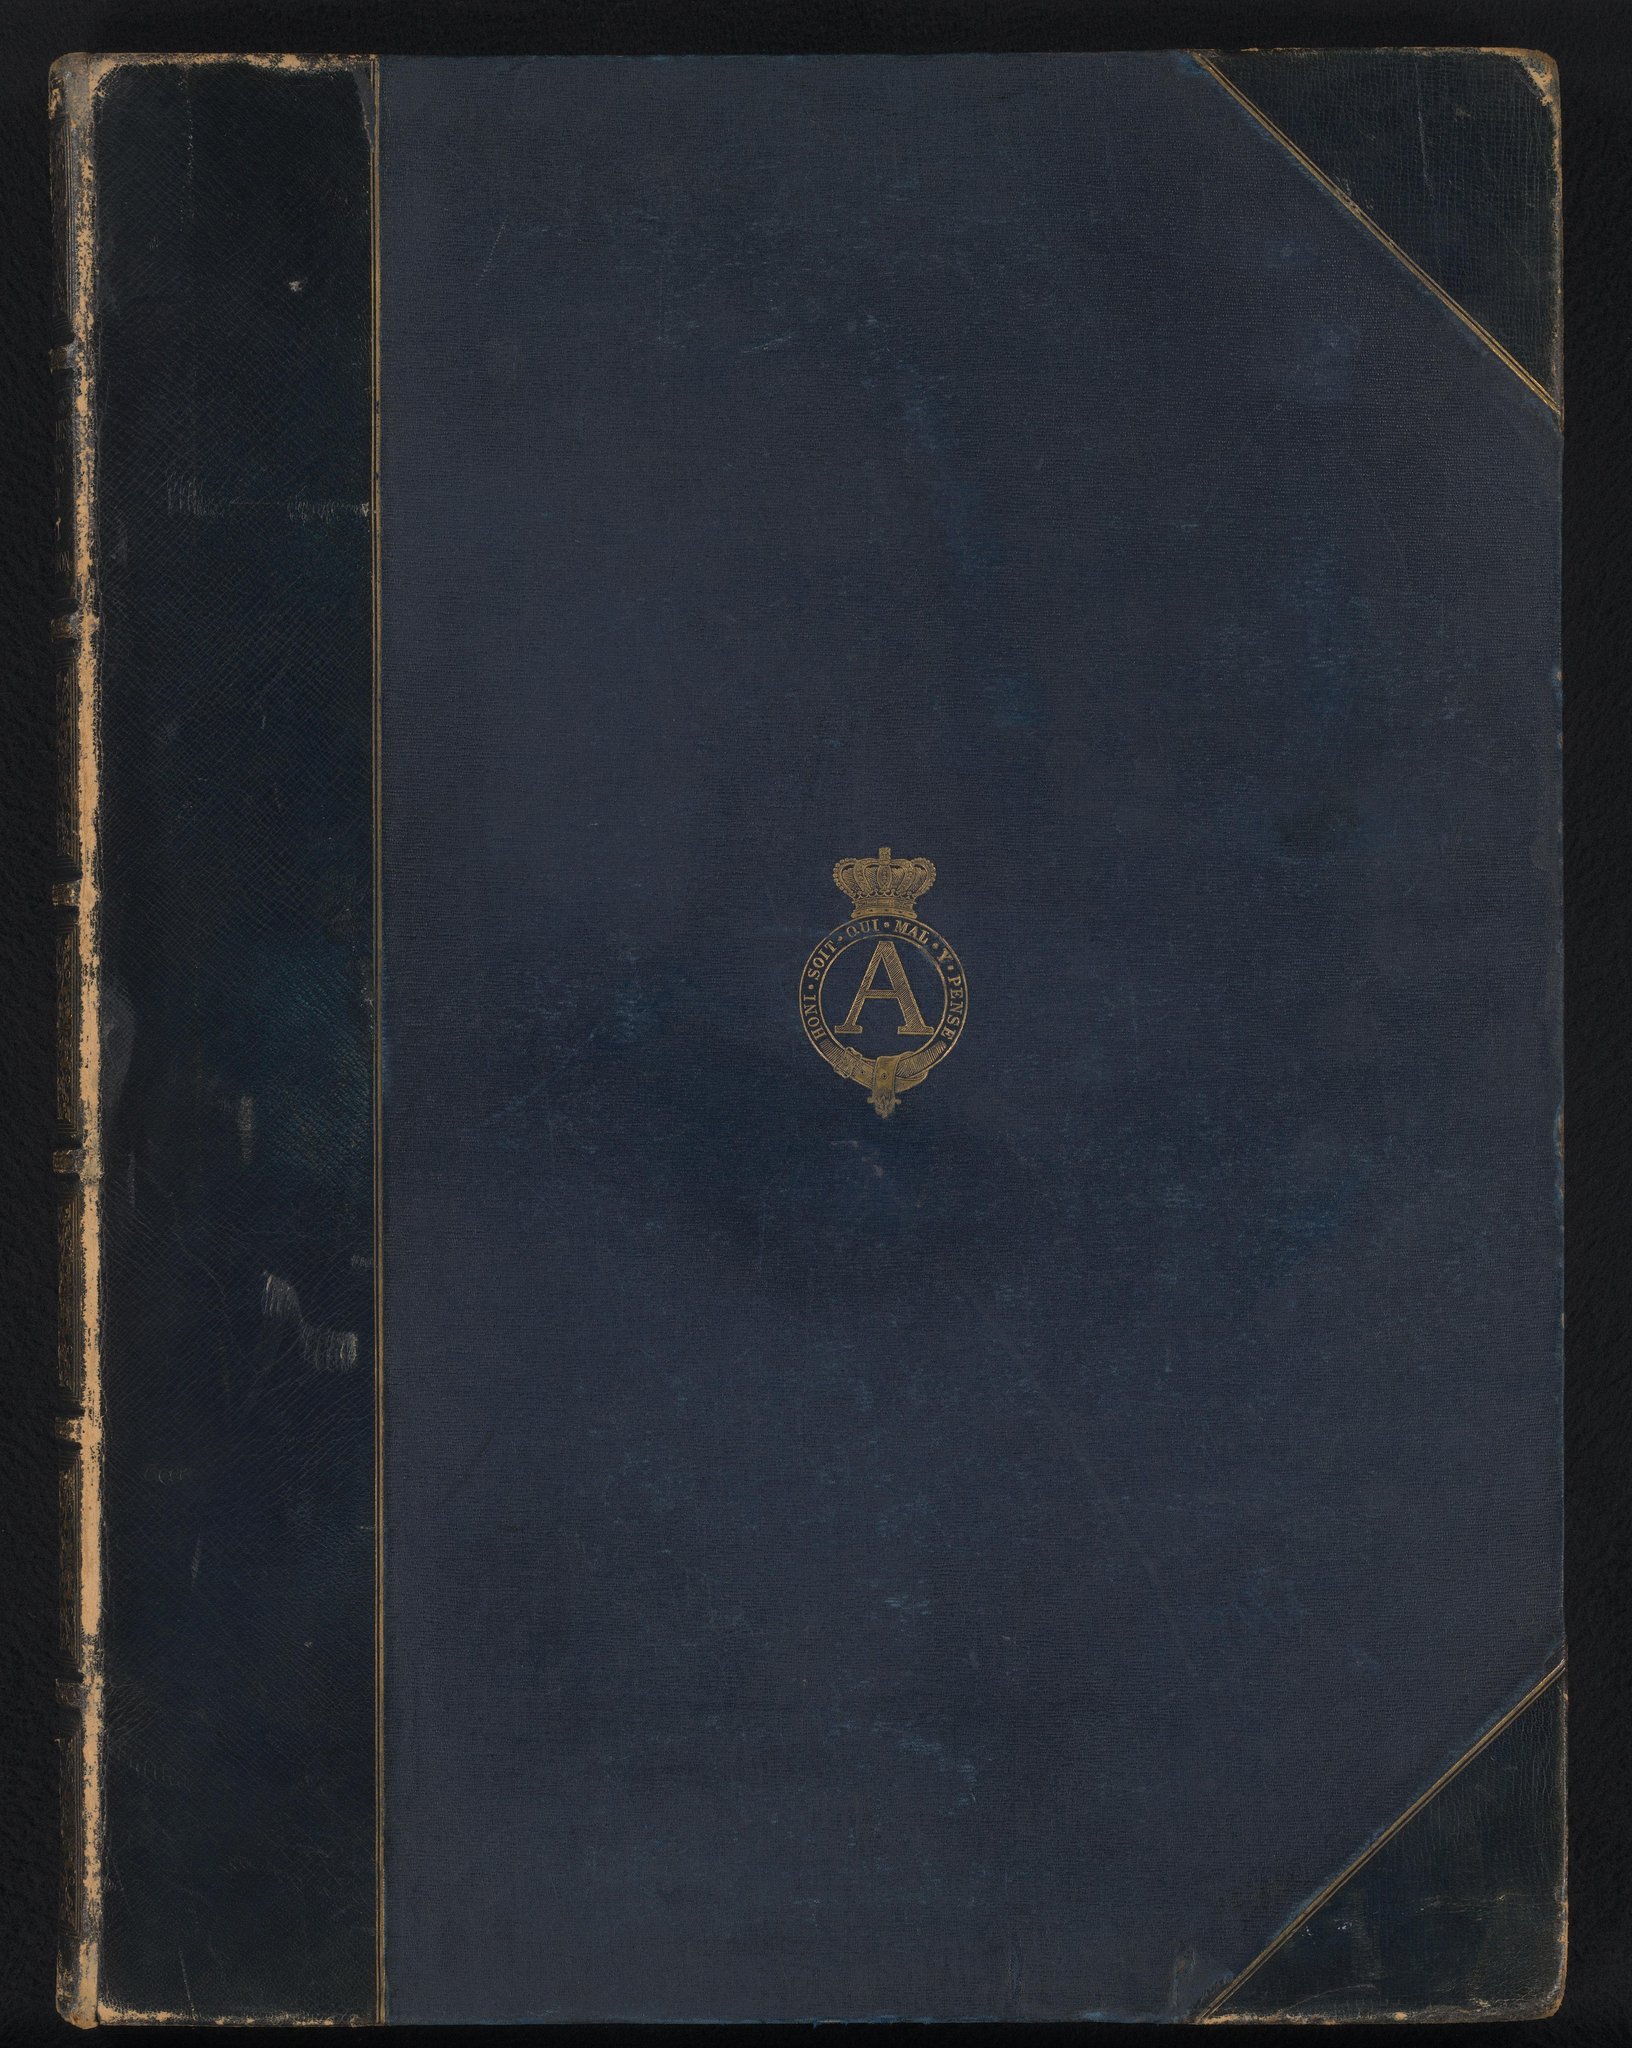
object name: book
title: Drawings by Raffaelle, in the Royal Collection at Winsor Castle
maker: Anonymous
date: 1857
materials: cardboard, leather, paper, textile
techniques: albumen print, marbling, printing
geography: london